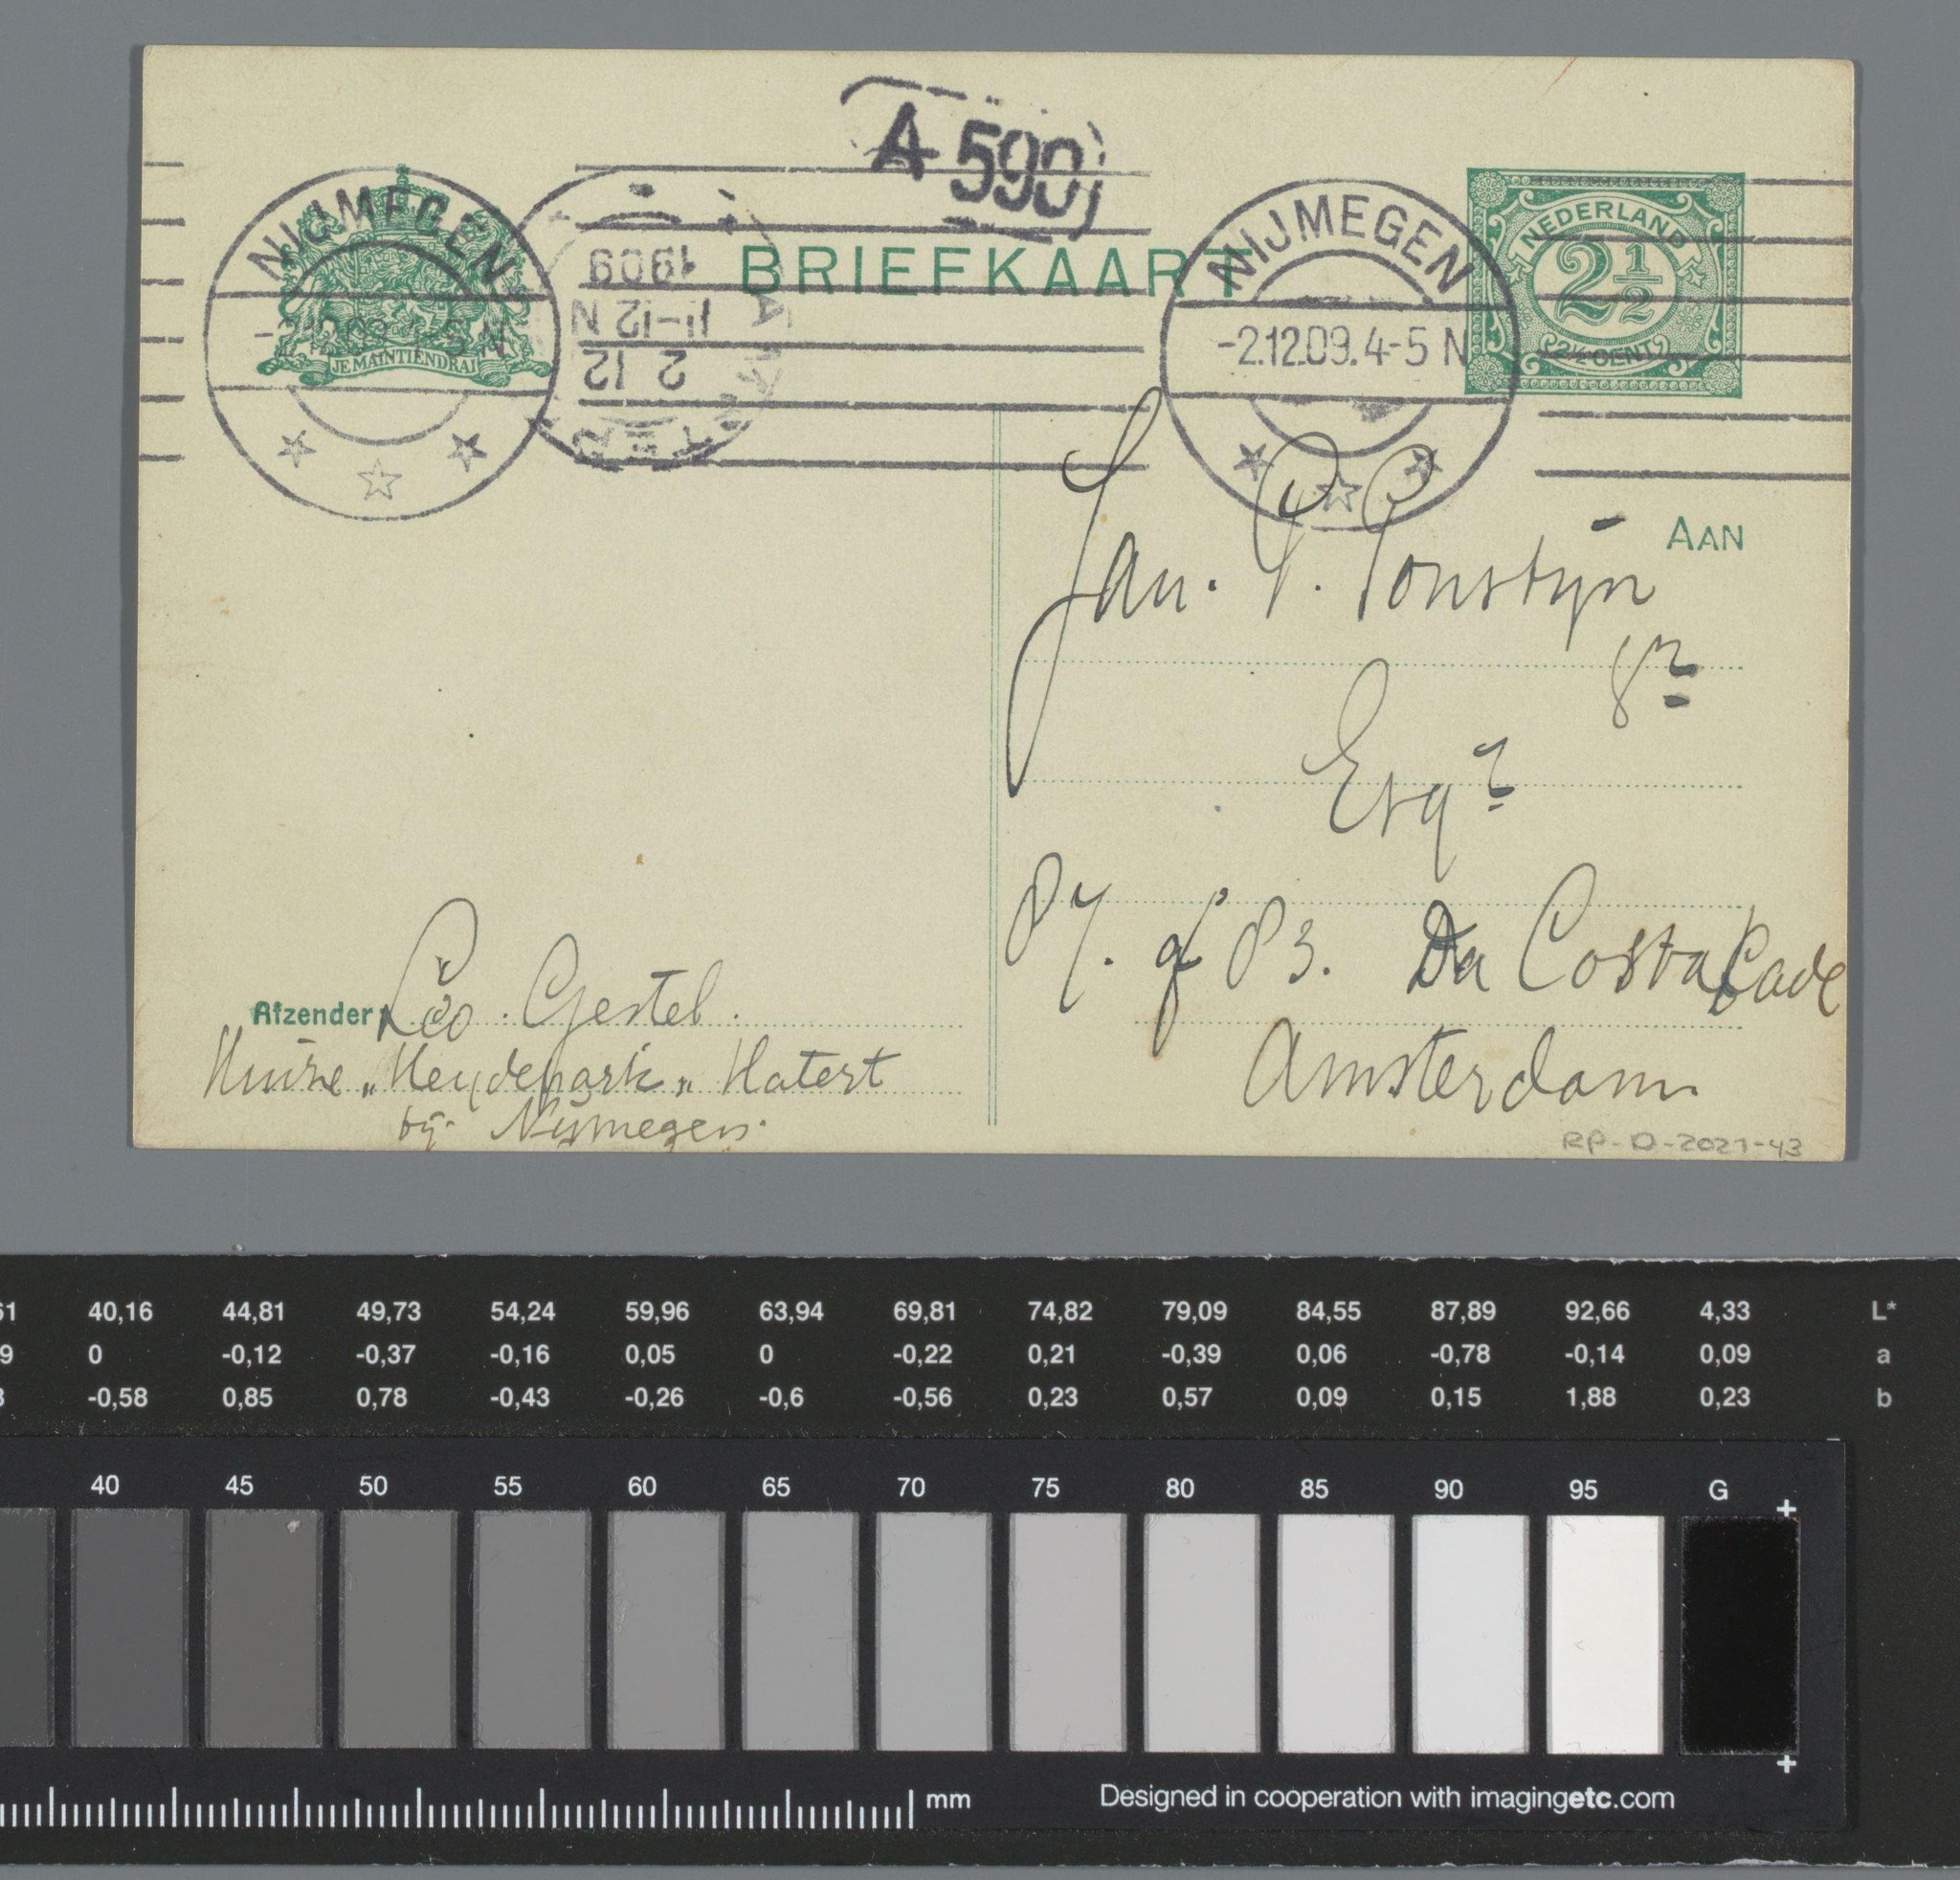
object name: postcard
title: Briefkaart aan Jan Ponstijn en Henriëtte Johanna Petronella van Hilten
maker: leo gestel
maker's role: draughtsman, print maker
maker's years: 1881-1941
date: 1909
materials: cardboard, ink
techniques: pen, writing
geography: hatert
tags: henriëtte johanna petronella ponstijn-van hilten, amsterdam, maker, harmina catharina baruch-ponstijn, jan petrus ponstijn, landscapes, confinement, birth